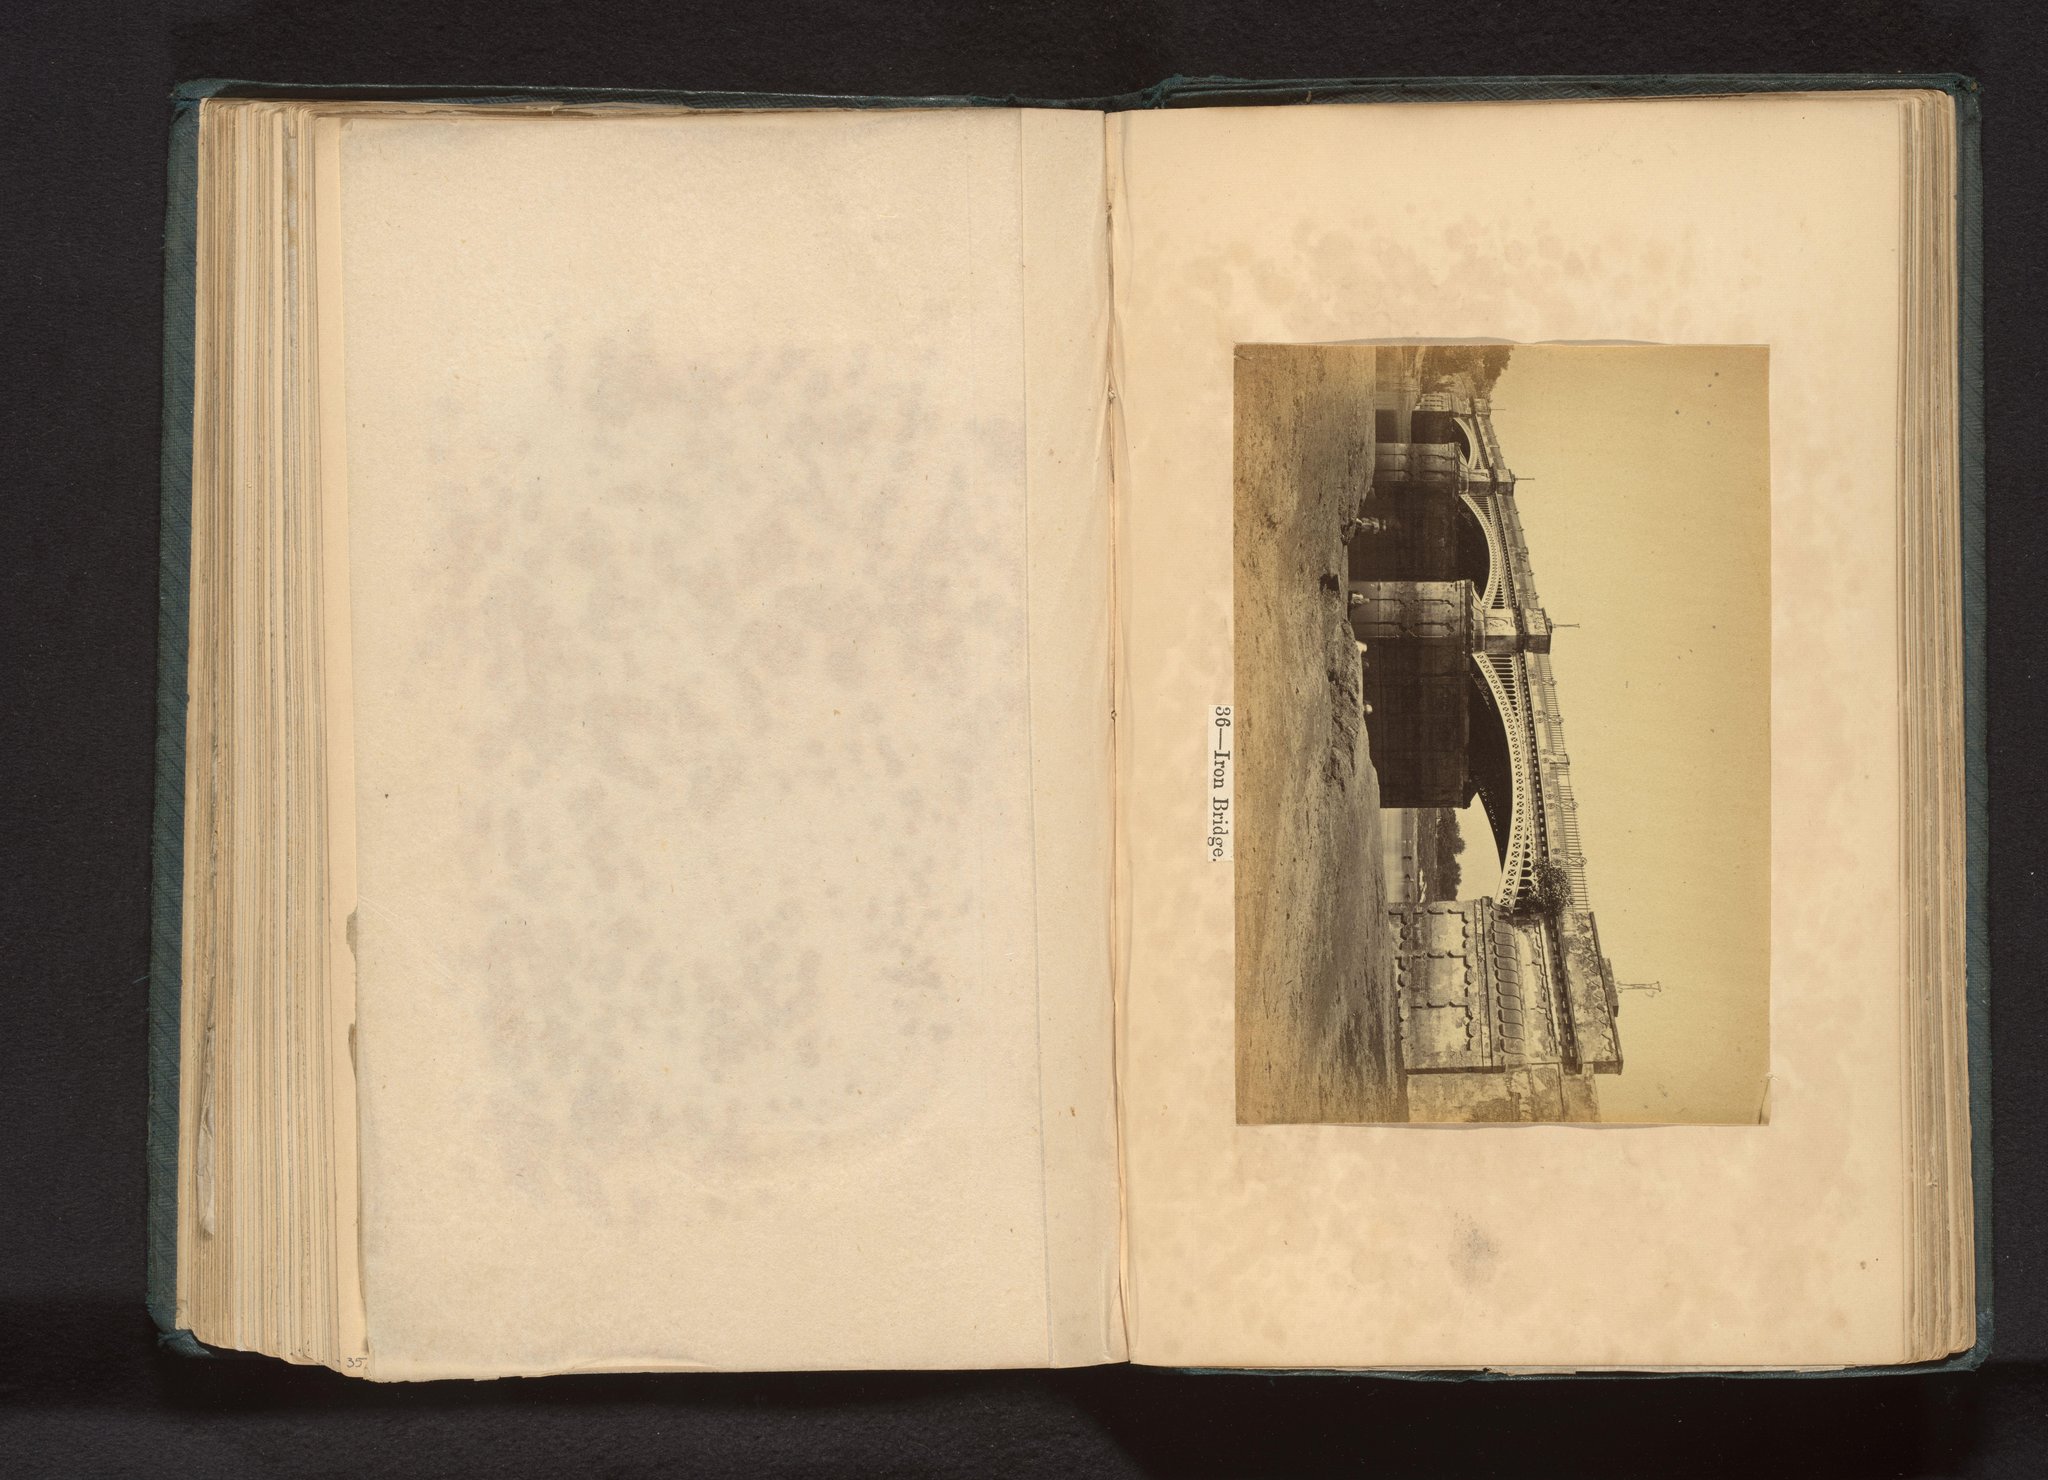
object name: photograph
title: Brug in Lucknow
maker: darogha ubbas alli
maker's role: fotograaf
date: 1864-1874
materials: photographic support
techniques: albumen print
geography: lucknow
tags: bridge in city across river, canal, etc.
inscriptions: number: ‘36’